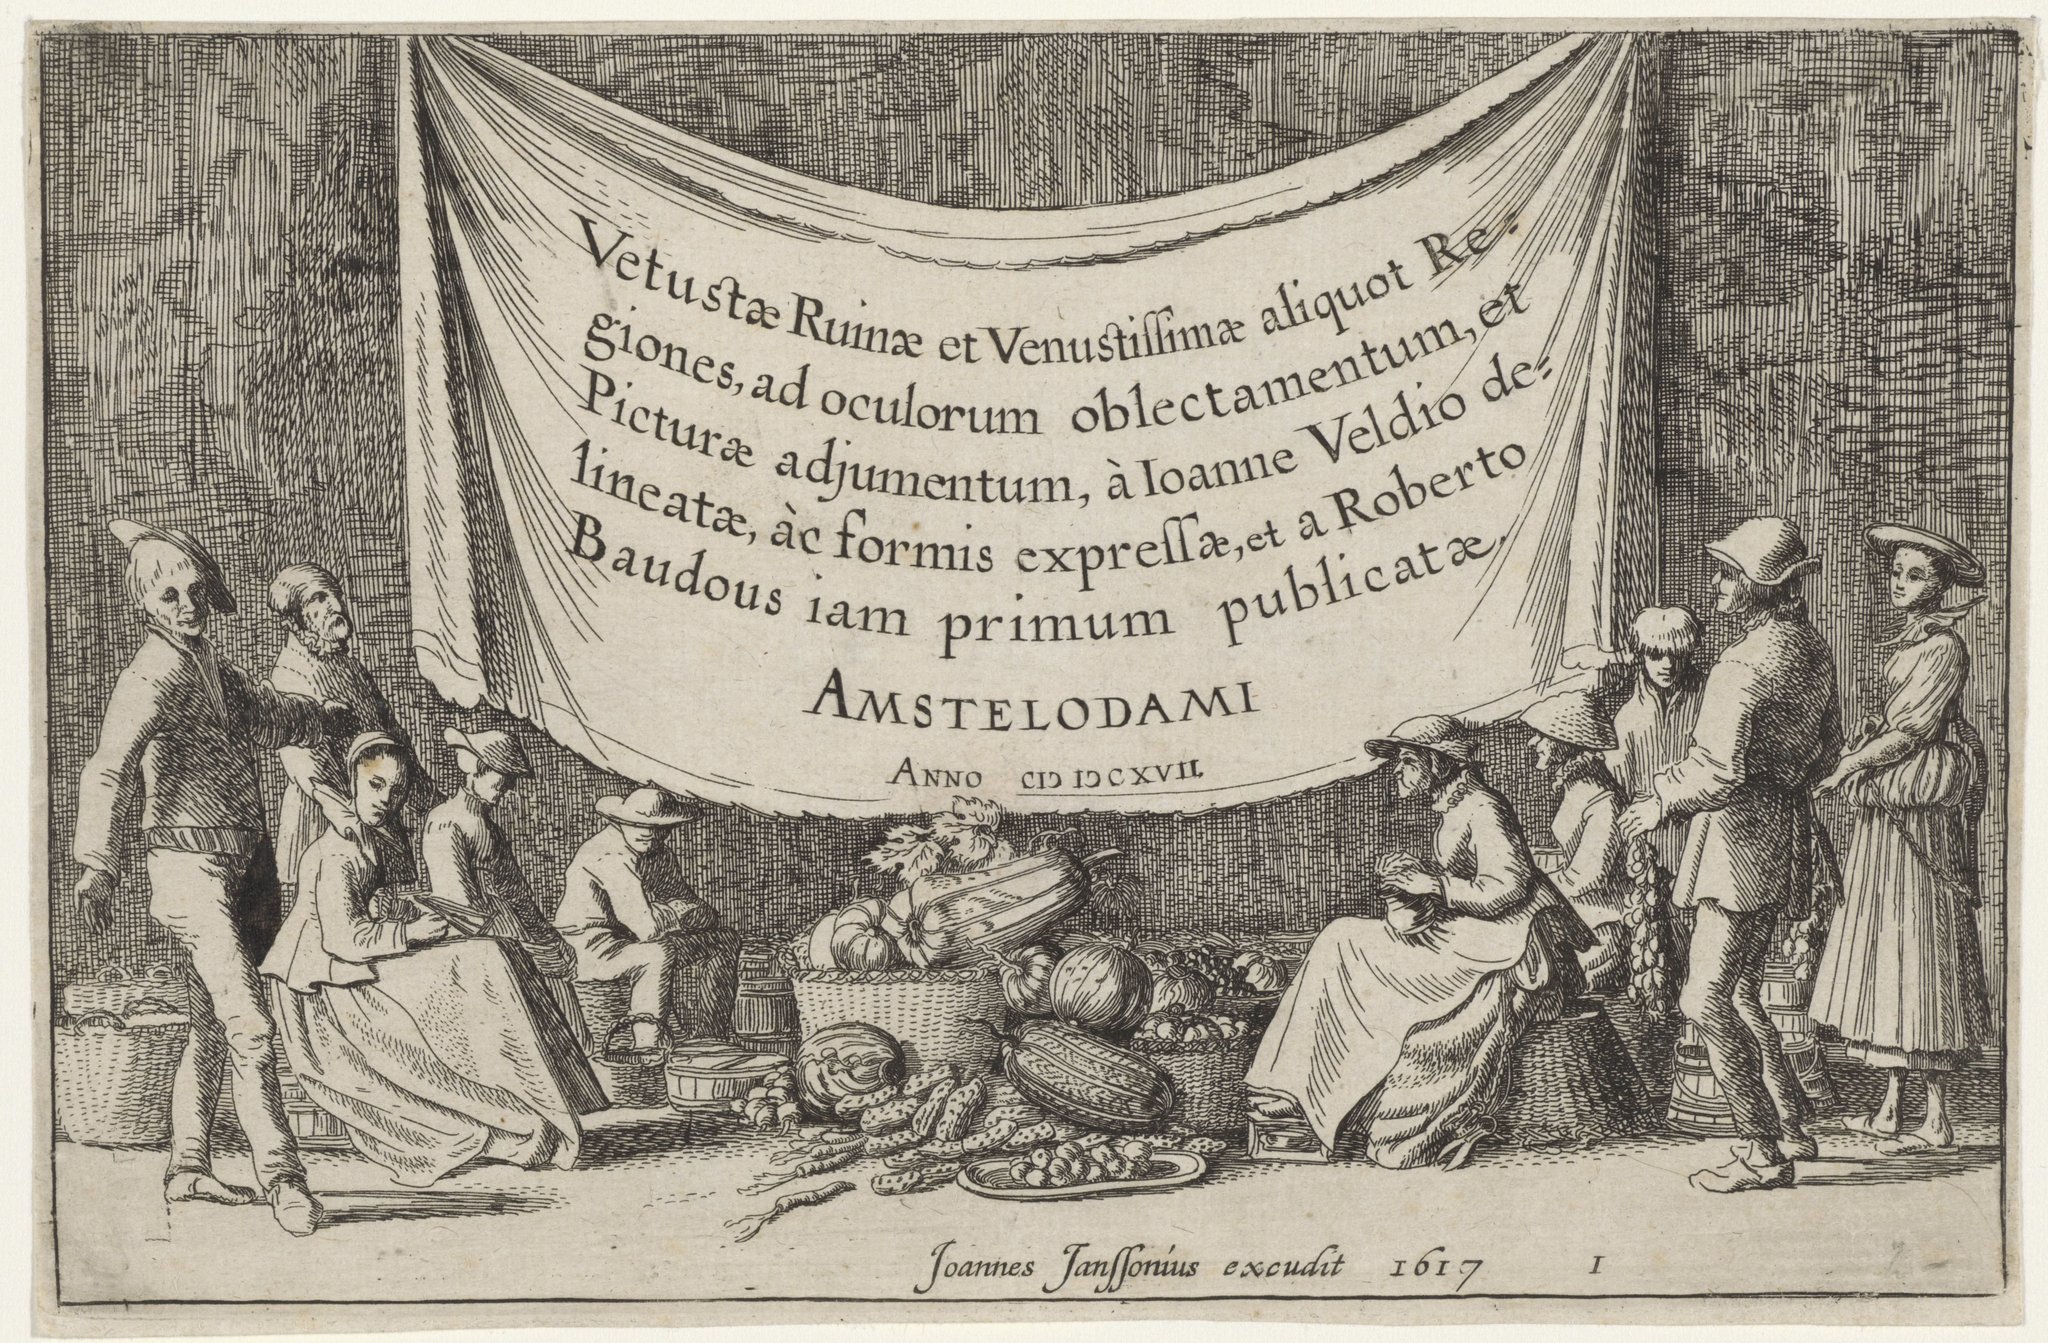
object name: titelprent, frontispice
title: Figuren bij manden met vruchten en groenten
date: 1617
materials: paper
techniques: etching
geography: northern netherlands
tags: vegetables, plants cultivated for their edible roots or tubers, e.g. potato, turnip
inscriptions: date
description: Figuren bij manden met vruchten en groenten, onder een doek waarop de titel. Titelprent van een serie van zestien.